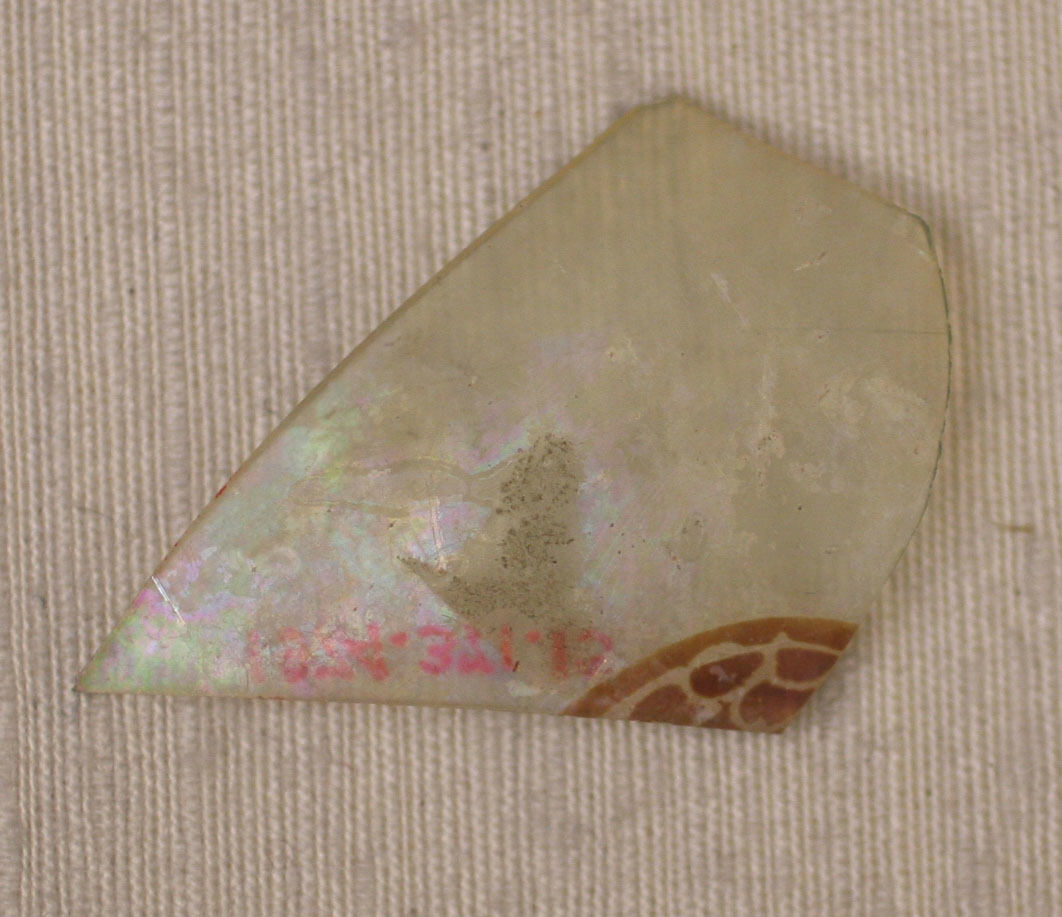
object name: fragment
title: Glass Fragment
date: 801-900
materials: glass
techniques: luster painting, stain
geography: egypt or iraq